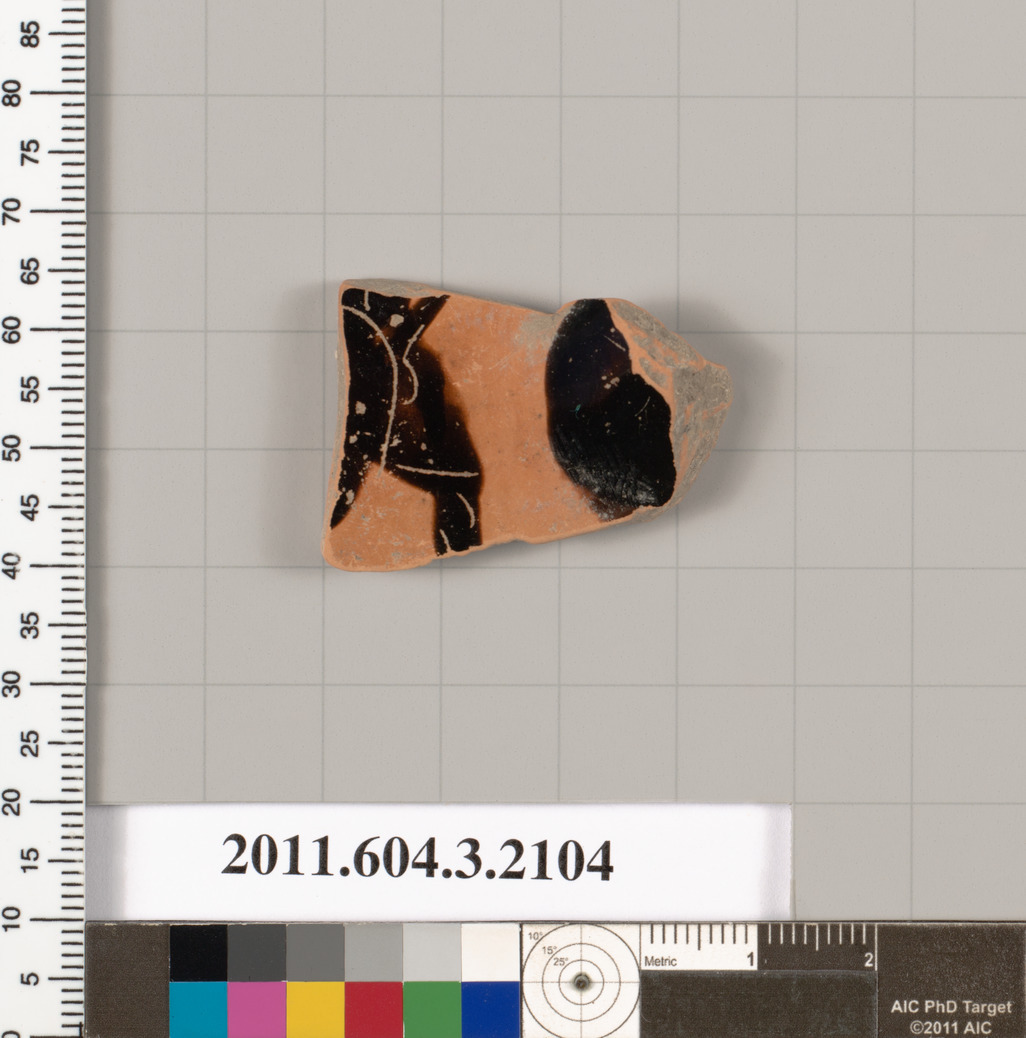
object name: kylix fragment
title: Terracotta fragment of a kylix (drinking cup)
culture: greek, attic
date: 534-468 BCE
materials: terracotta